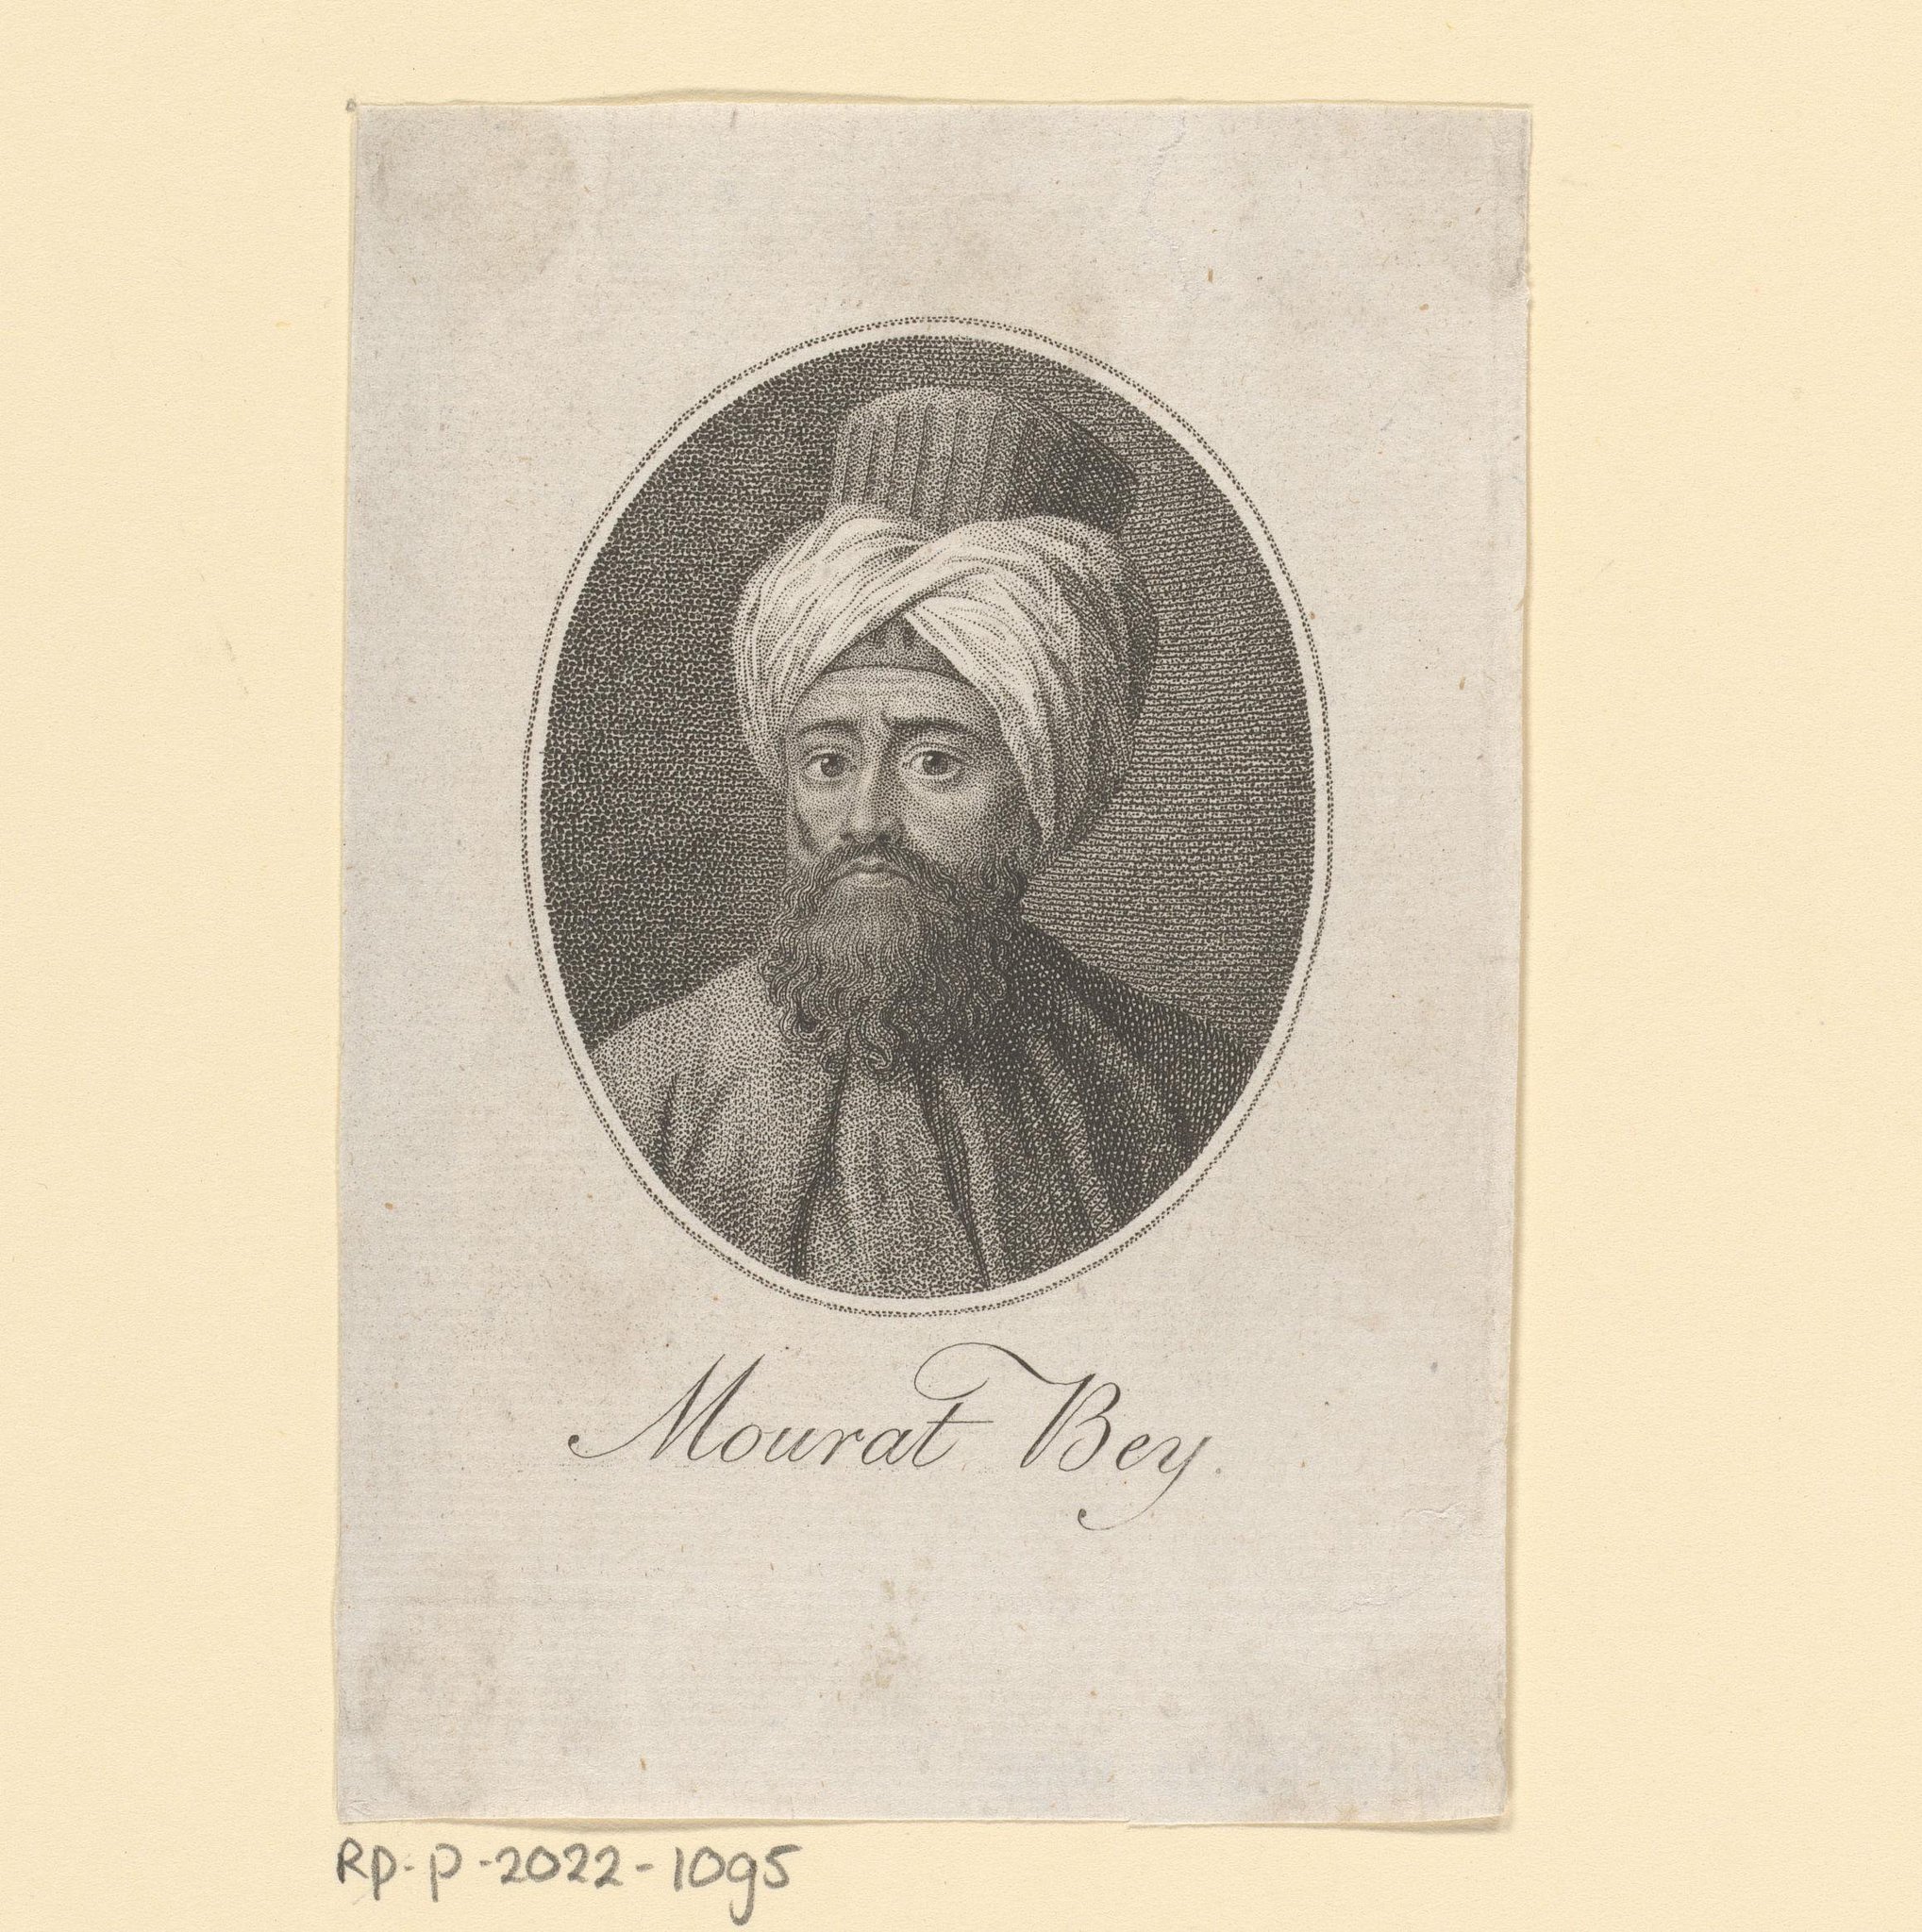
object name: print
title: Portret van Murat Bey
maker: Anonymous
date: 1770-1899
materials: paper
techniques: etching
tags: commander-in-chief, general, marshal, historical persons, head-gear: turban